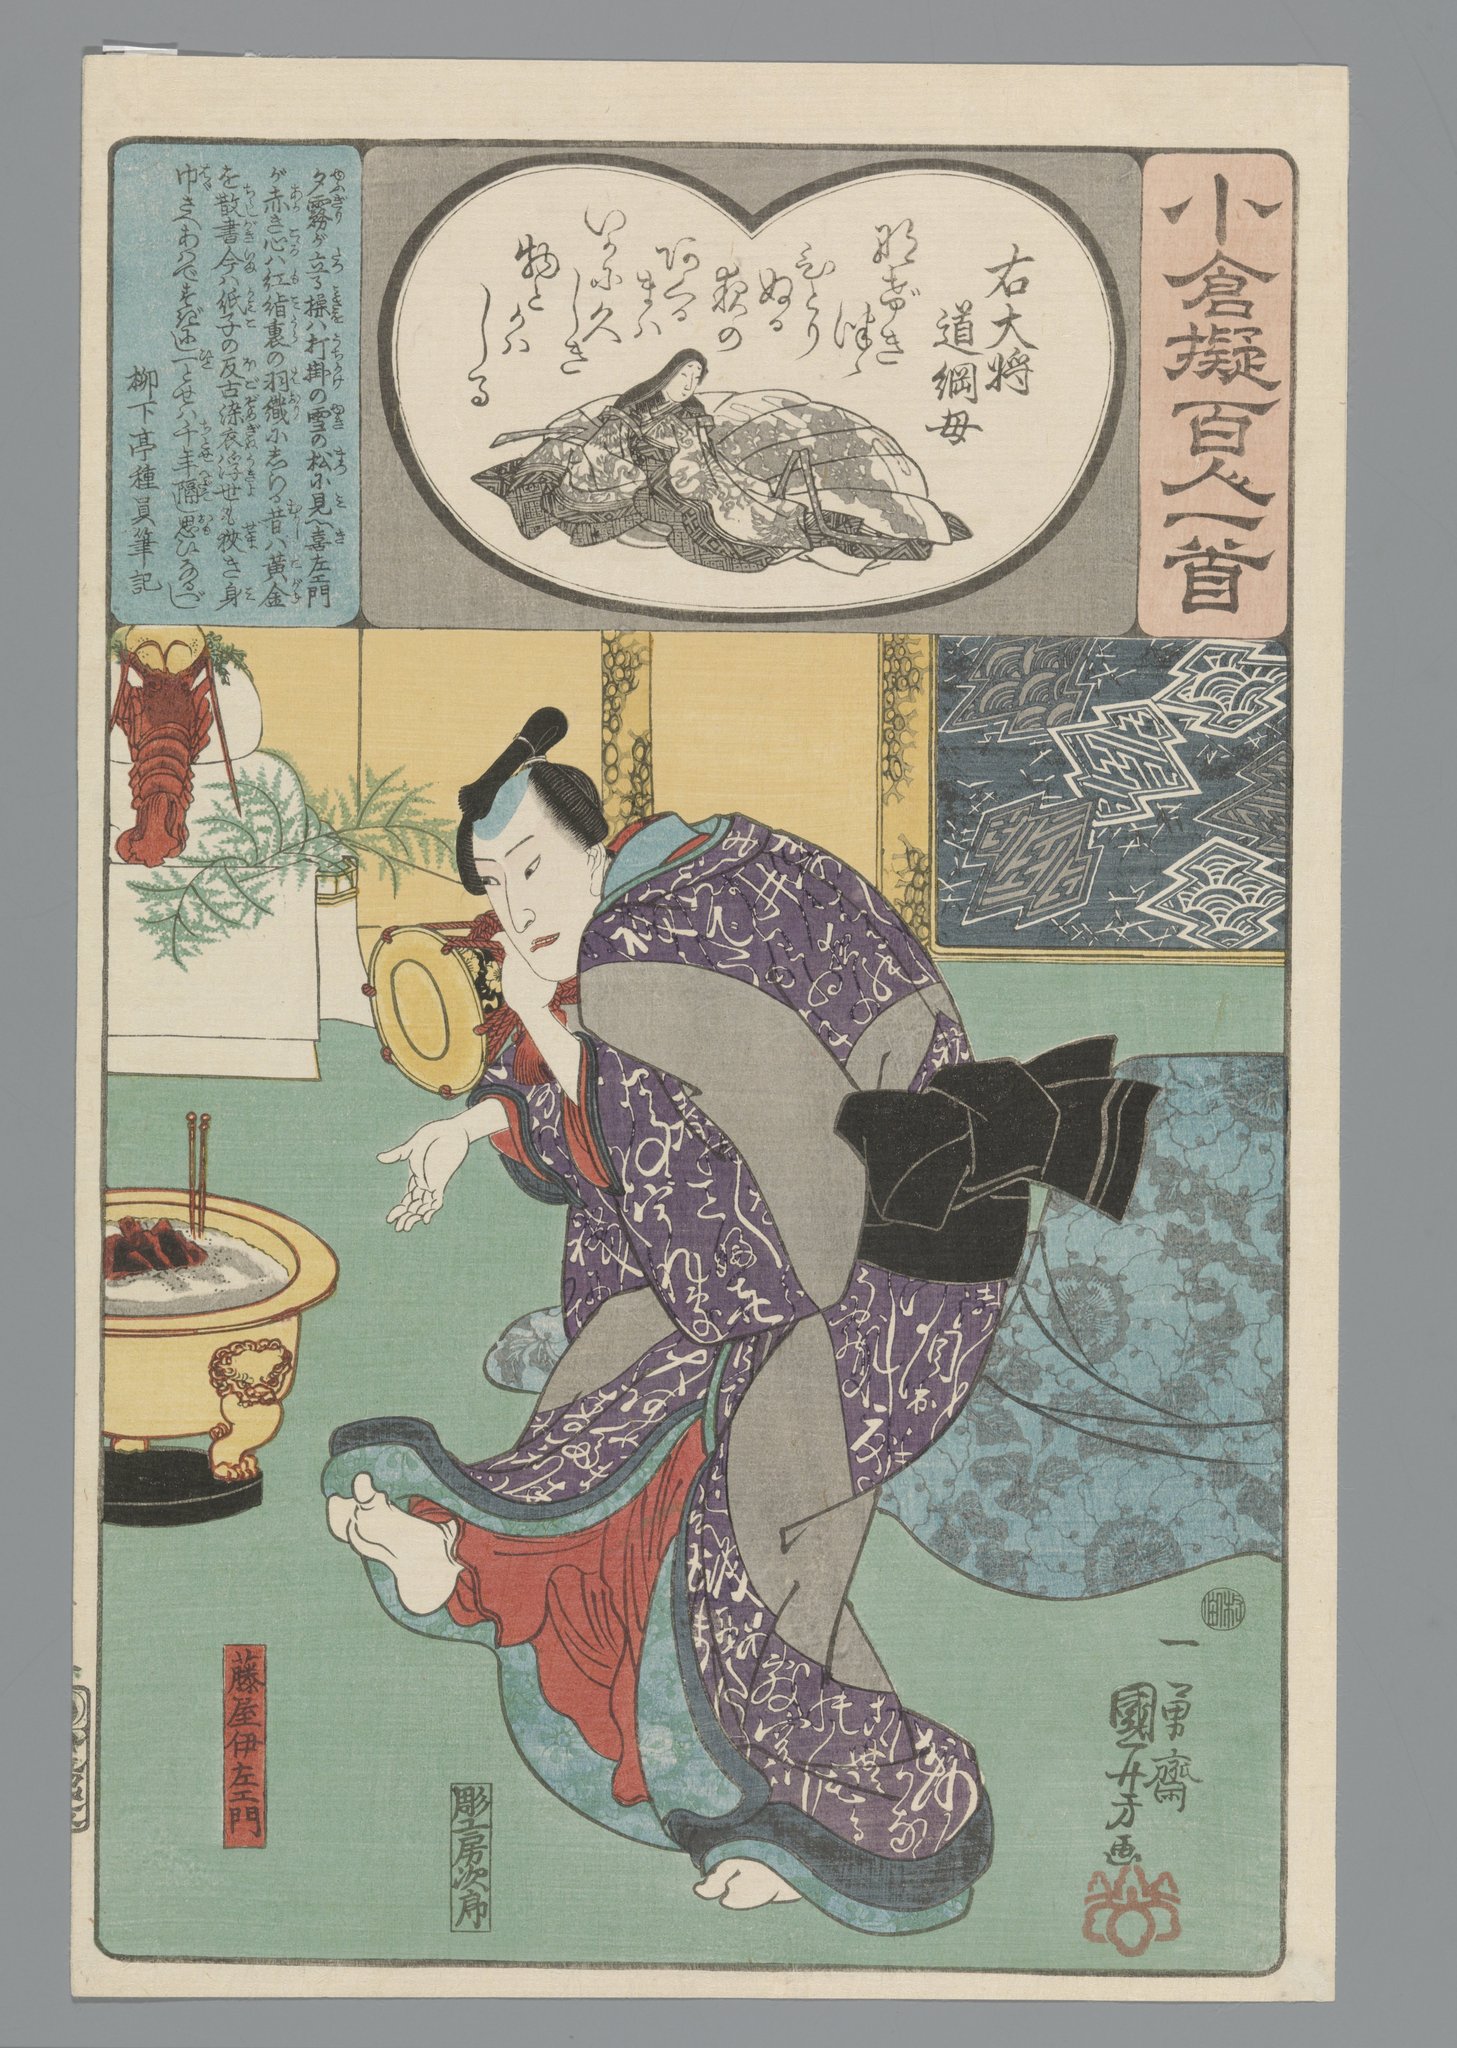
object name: print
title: Ogura Imitation of the One Hundred Poems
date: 1846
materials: paper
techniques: woodcut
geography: japan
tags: adult man, drum (musical instrument)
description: Fujiya Izaemon met trommel, in een kimono gemaakt van liefdesbrieven. Izaemon was tot armoede vervallen en had alleen nog maar een papieren kimono gemaakt van oude liefdesbrieven en rode onderkimono van zijn voormalige geliefde om te dragen. Scene uit een kabukitoneelstuk. Gedicht door de moeder van Udaishô Michitsuna.